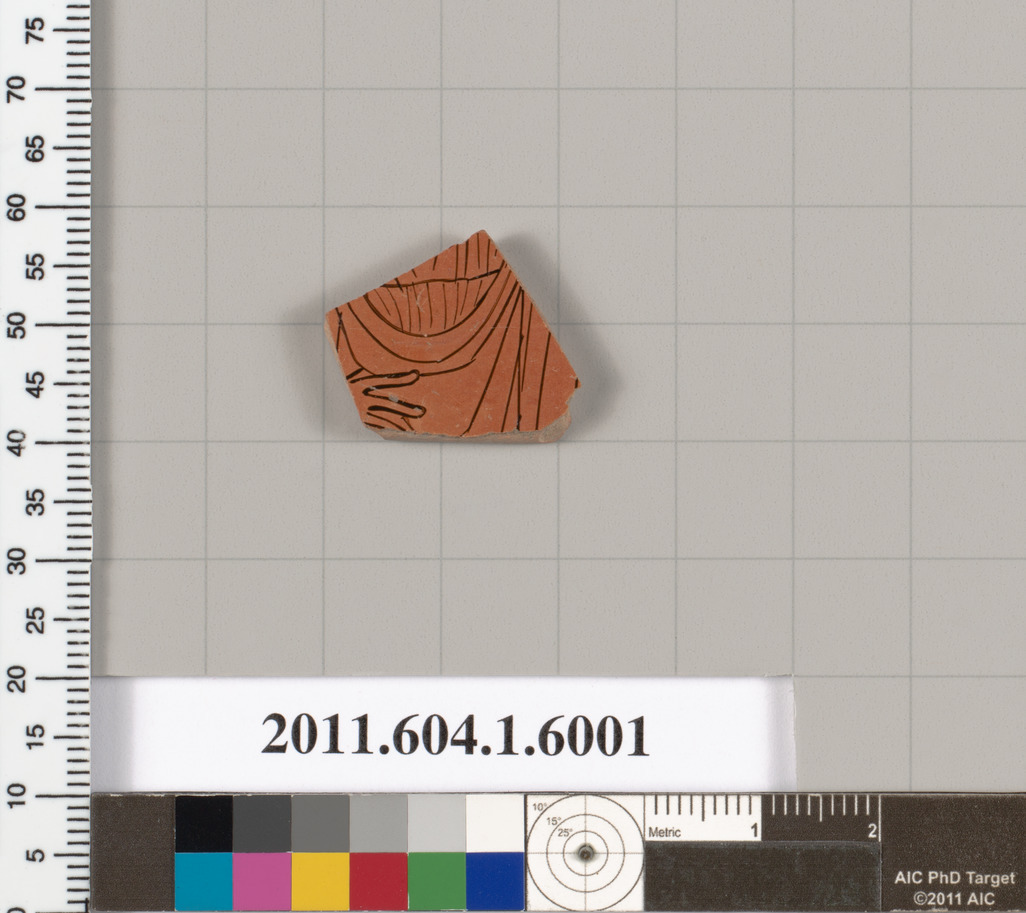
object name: kylix fragment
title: Terracotta fragment of a kylix (drinking cup)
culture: greek, attic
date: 510-500 BCE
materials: terracotta